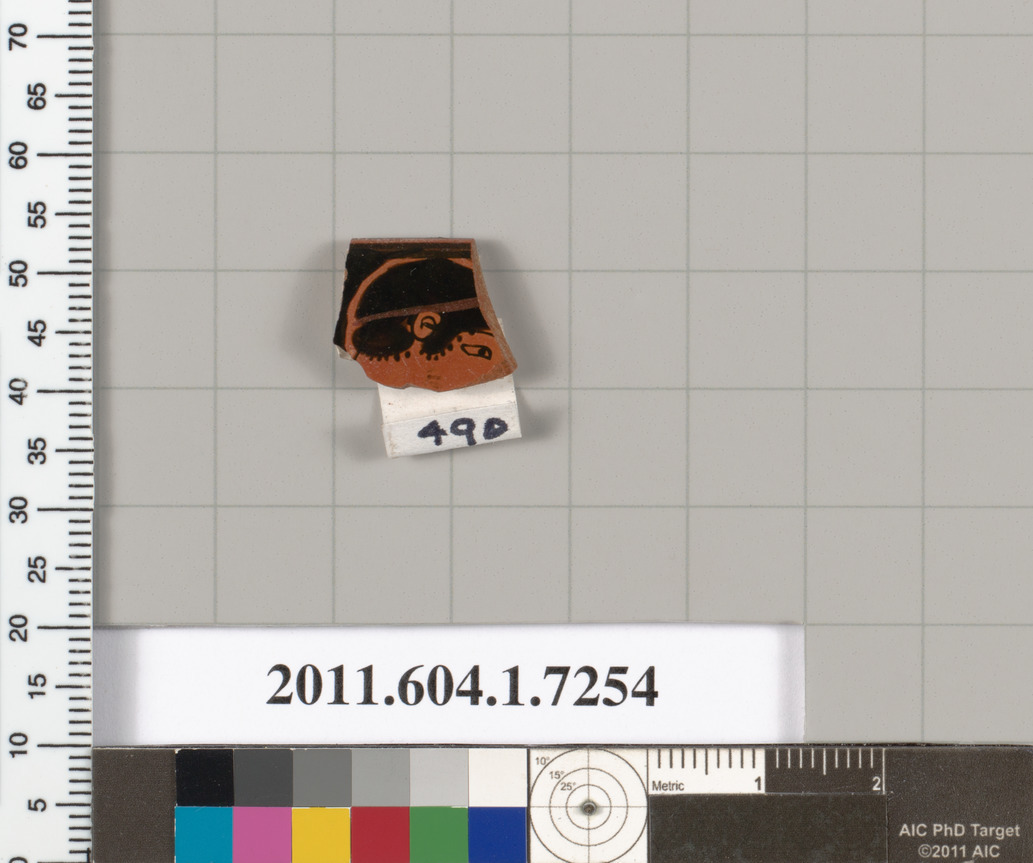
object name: kylix fragment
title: Terracotta rim fragment of a kylix (drinking cup)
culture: greek, attic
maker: makron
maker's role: artist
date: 500-480 BCE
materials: terracotta